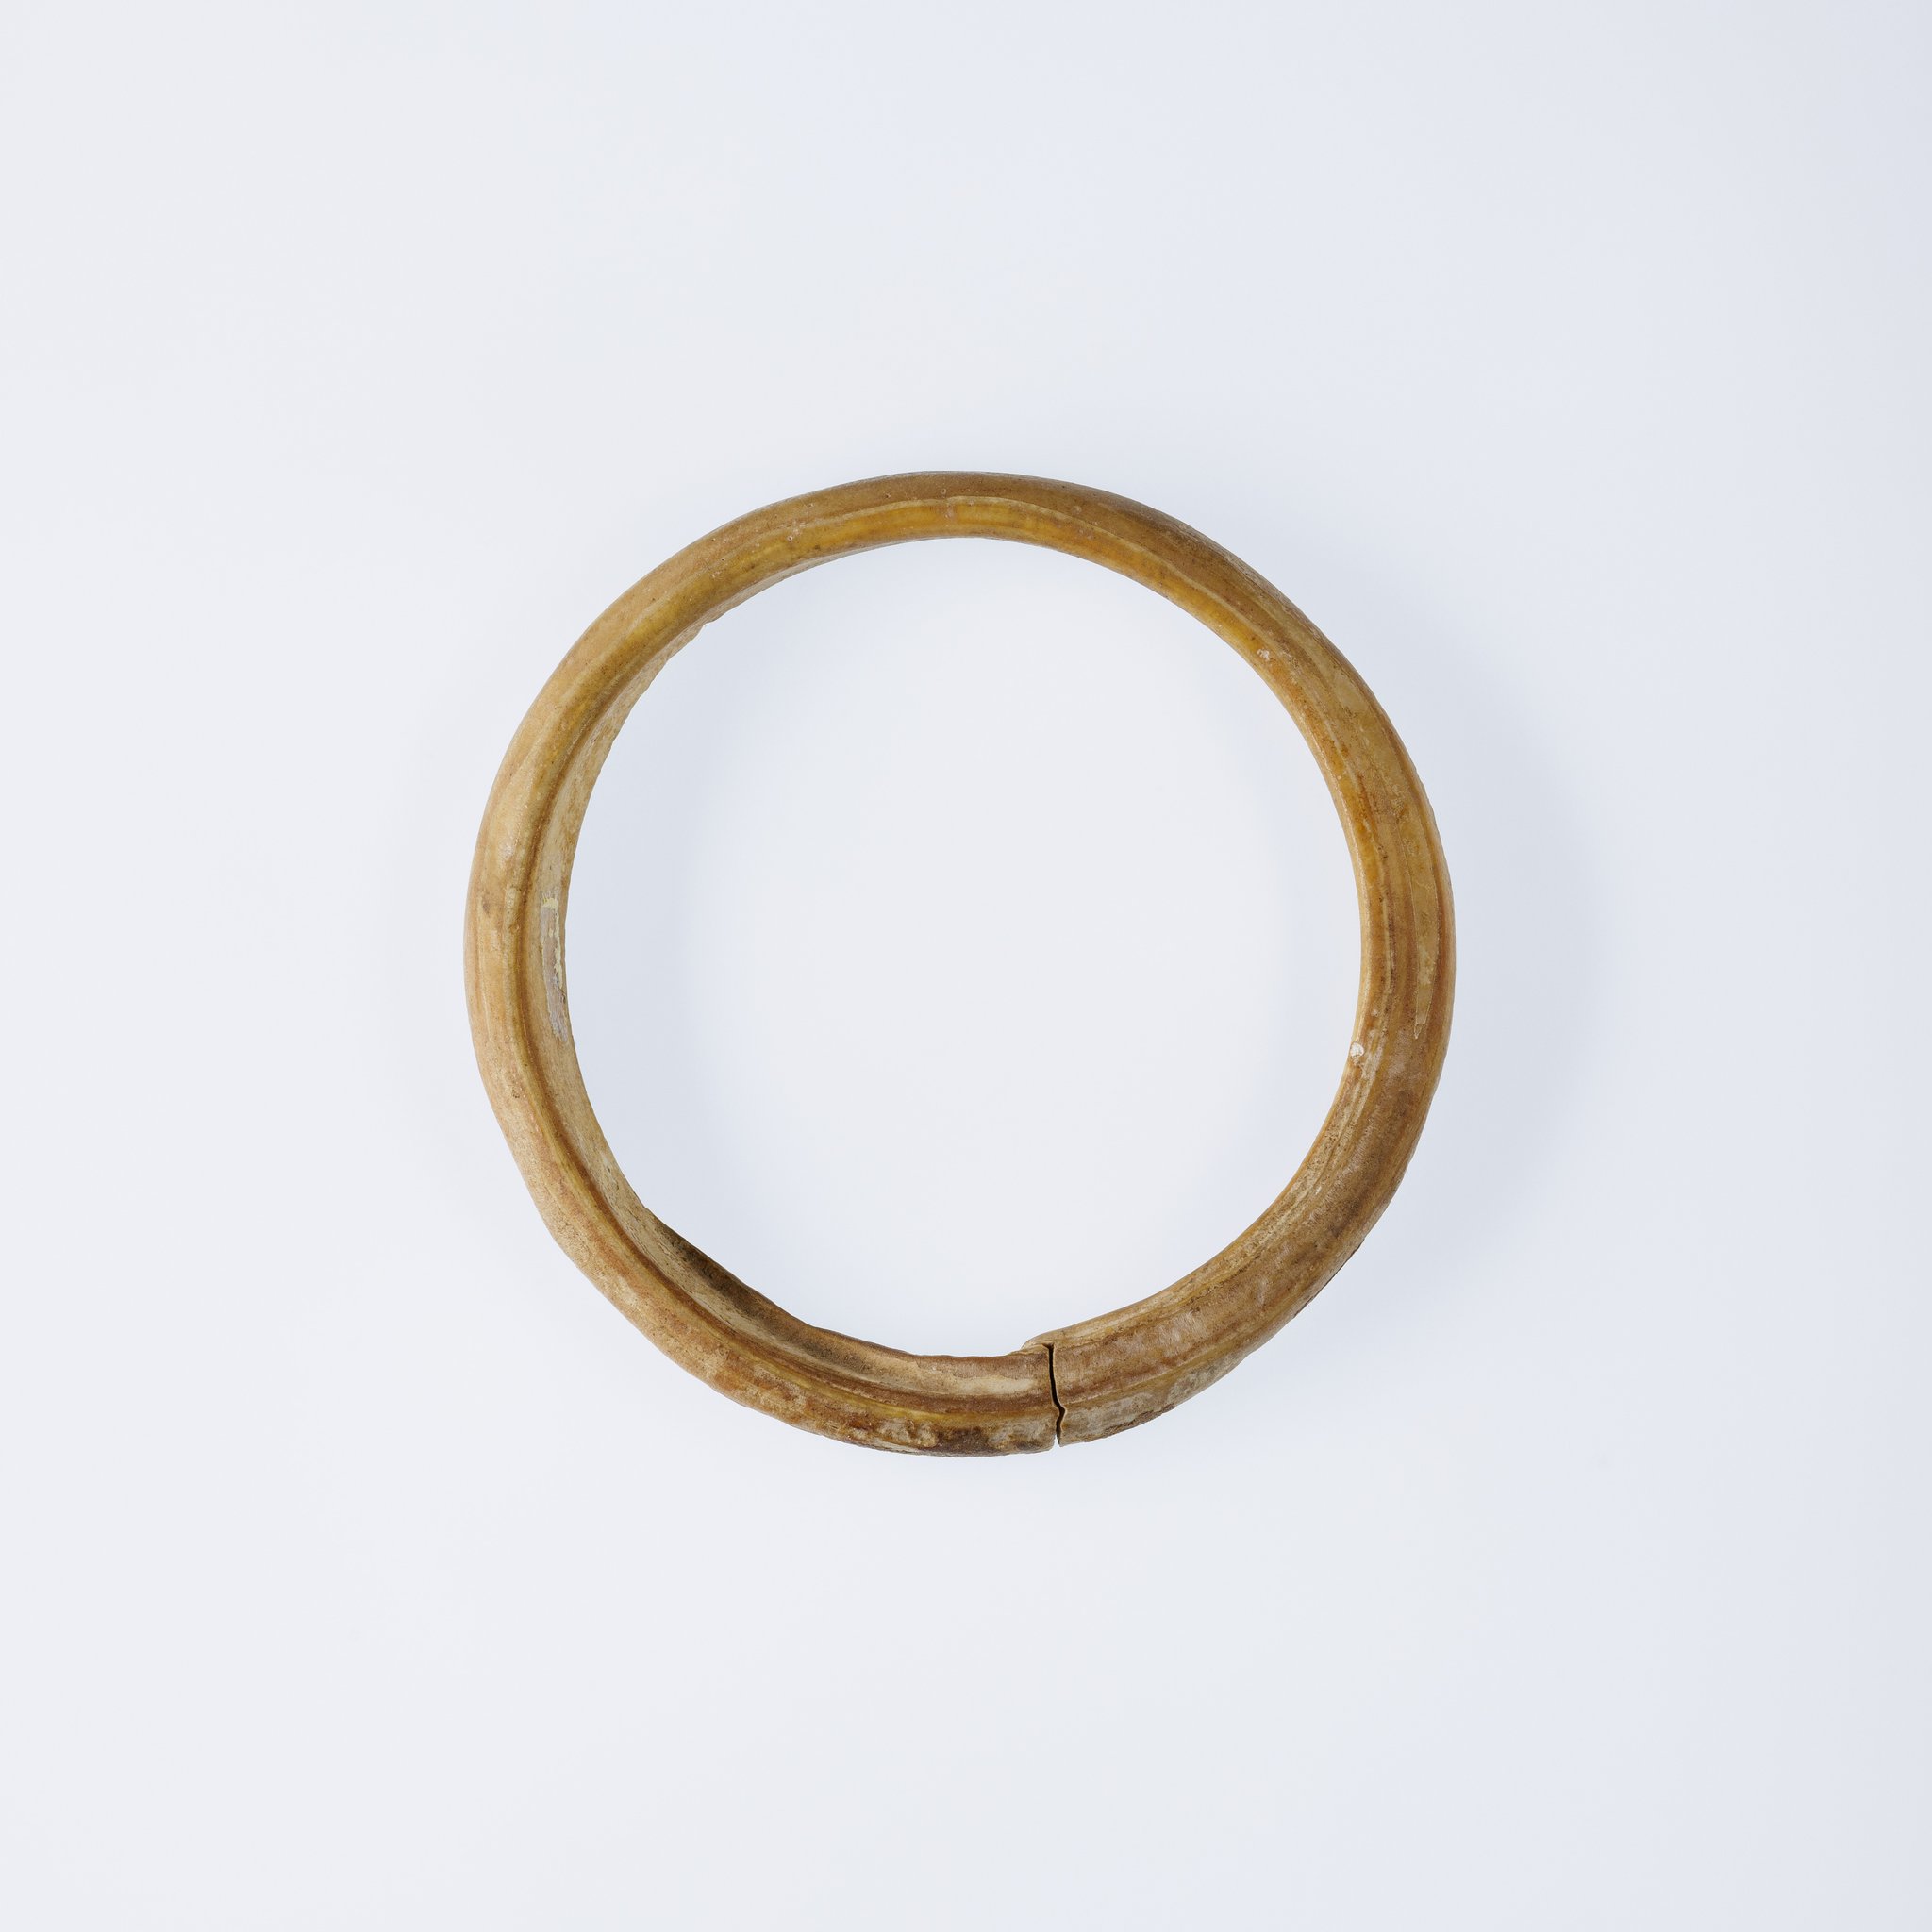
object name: bracelet bangle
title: Bangle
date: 3850-2960 BCE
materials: shell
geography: egypt